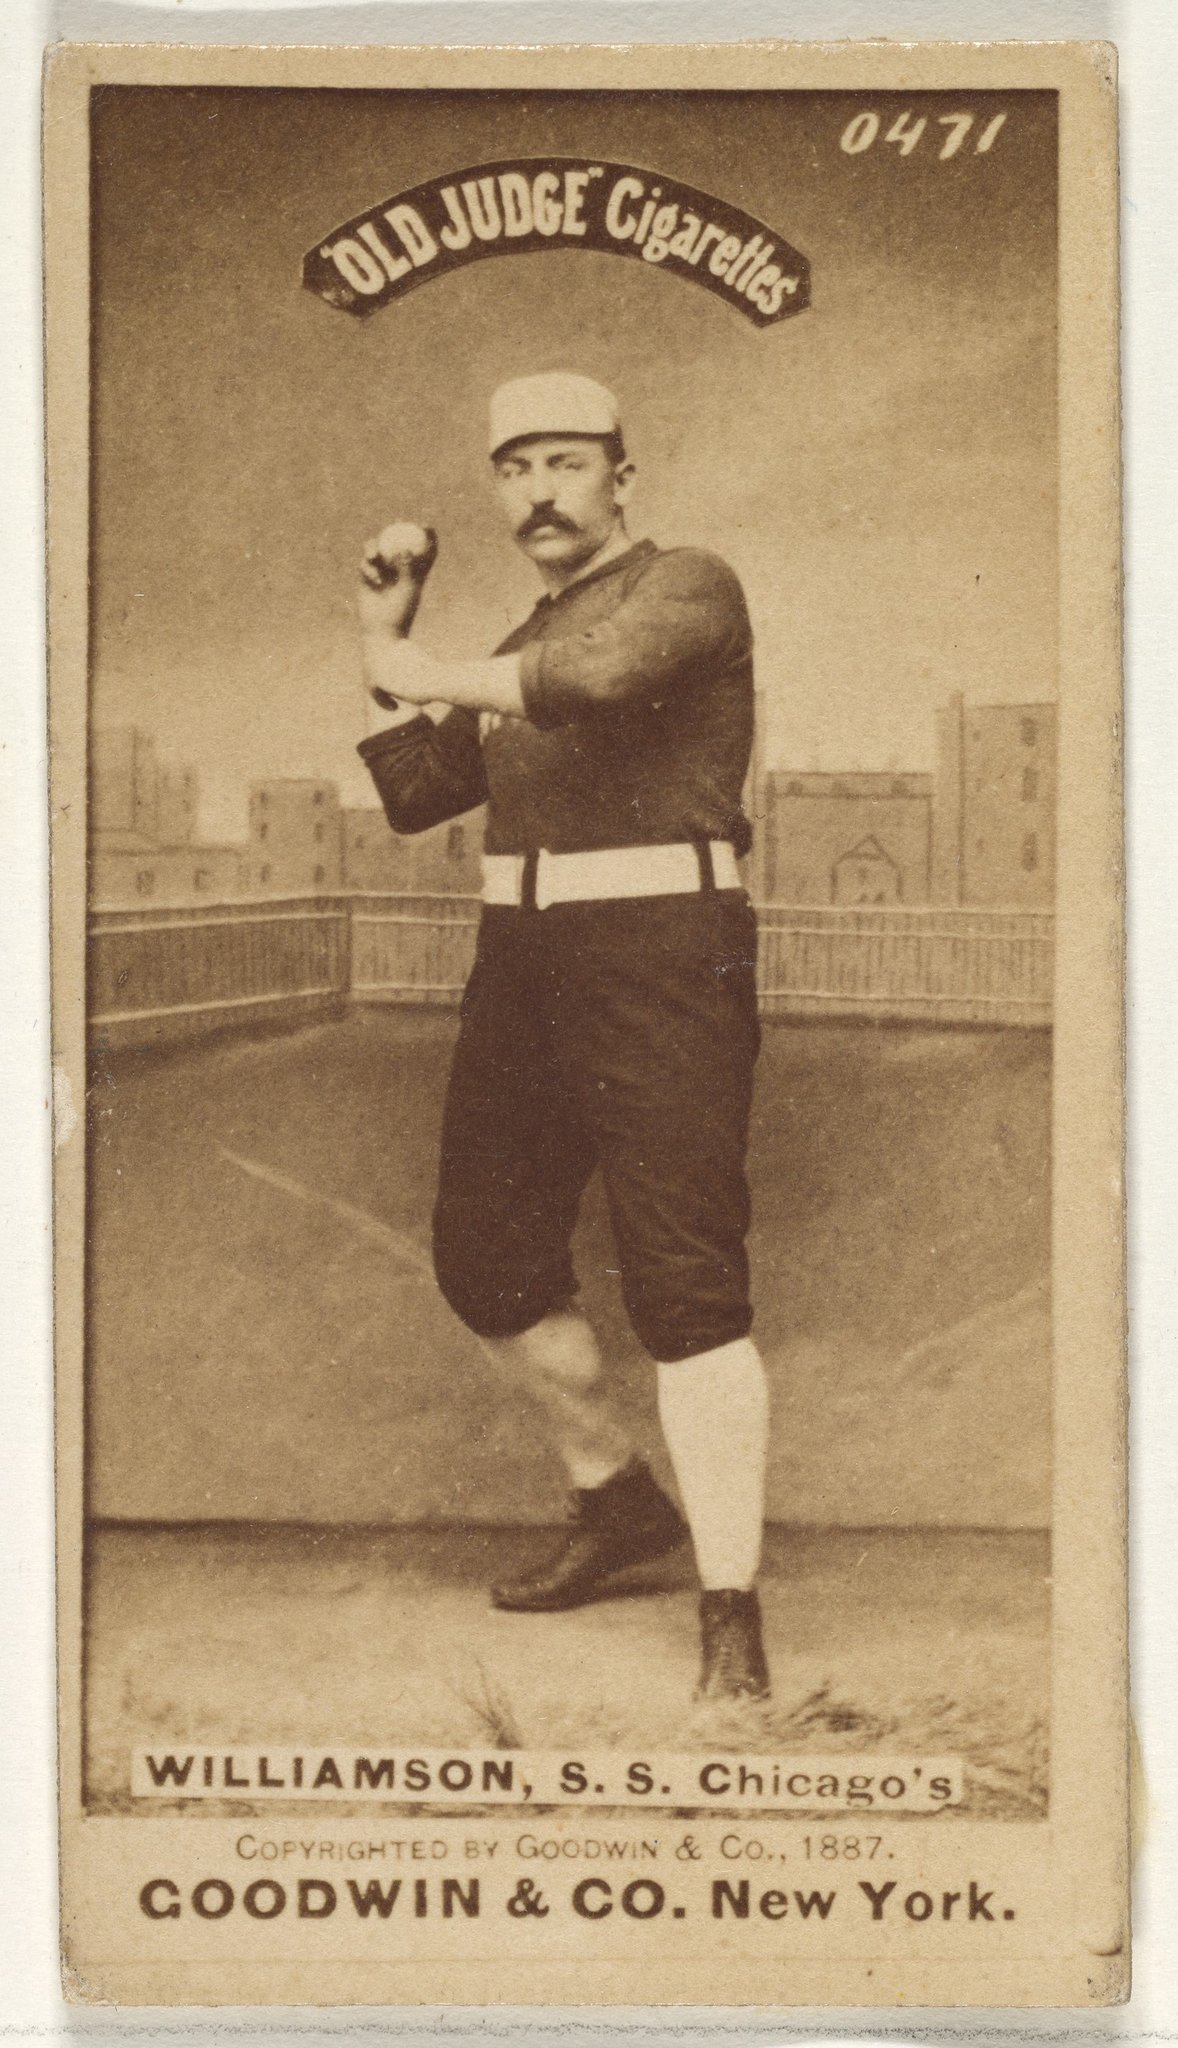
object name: baseball card, photograph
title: Williamson, Shortstop, Chicago, from the Old Judge series (N172) for Old Judge Cigarettes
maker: goodwin & company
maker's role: publisher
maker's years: 1850-1950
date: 1887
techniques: albumen silver print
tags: men,portraits,baseball,athletes